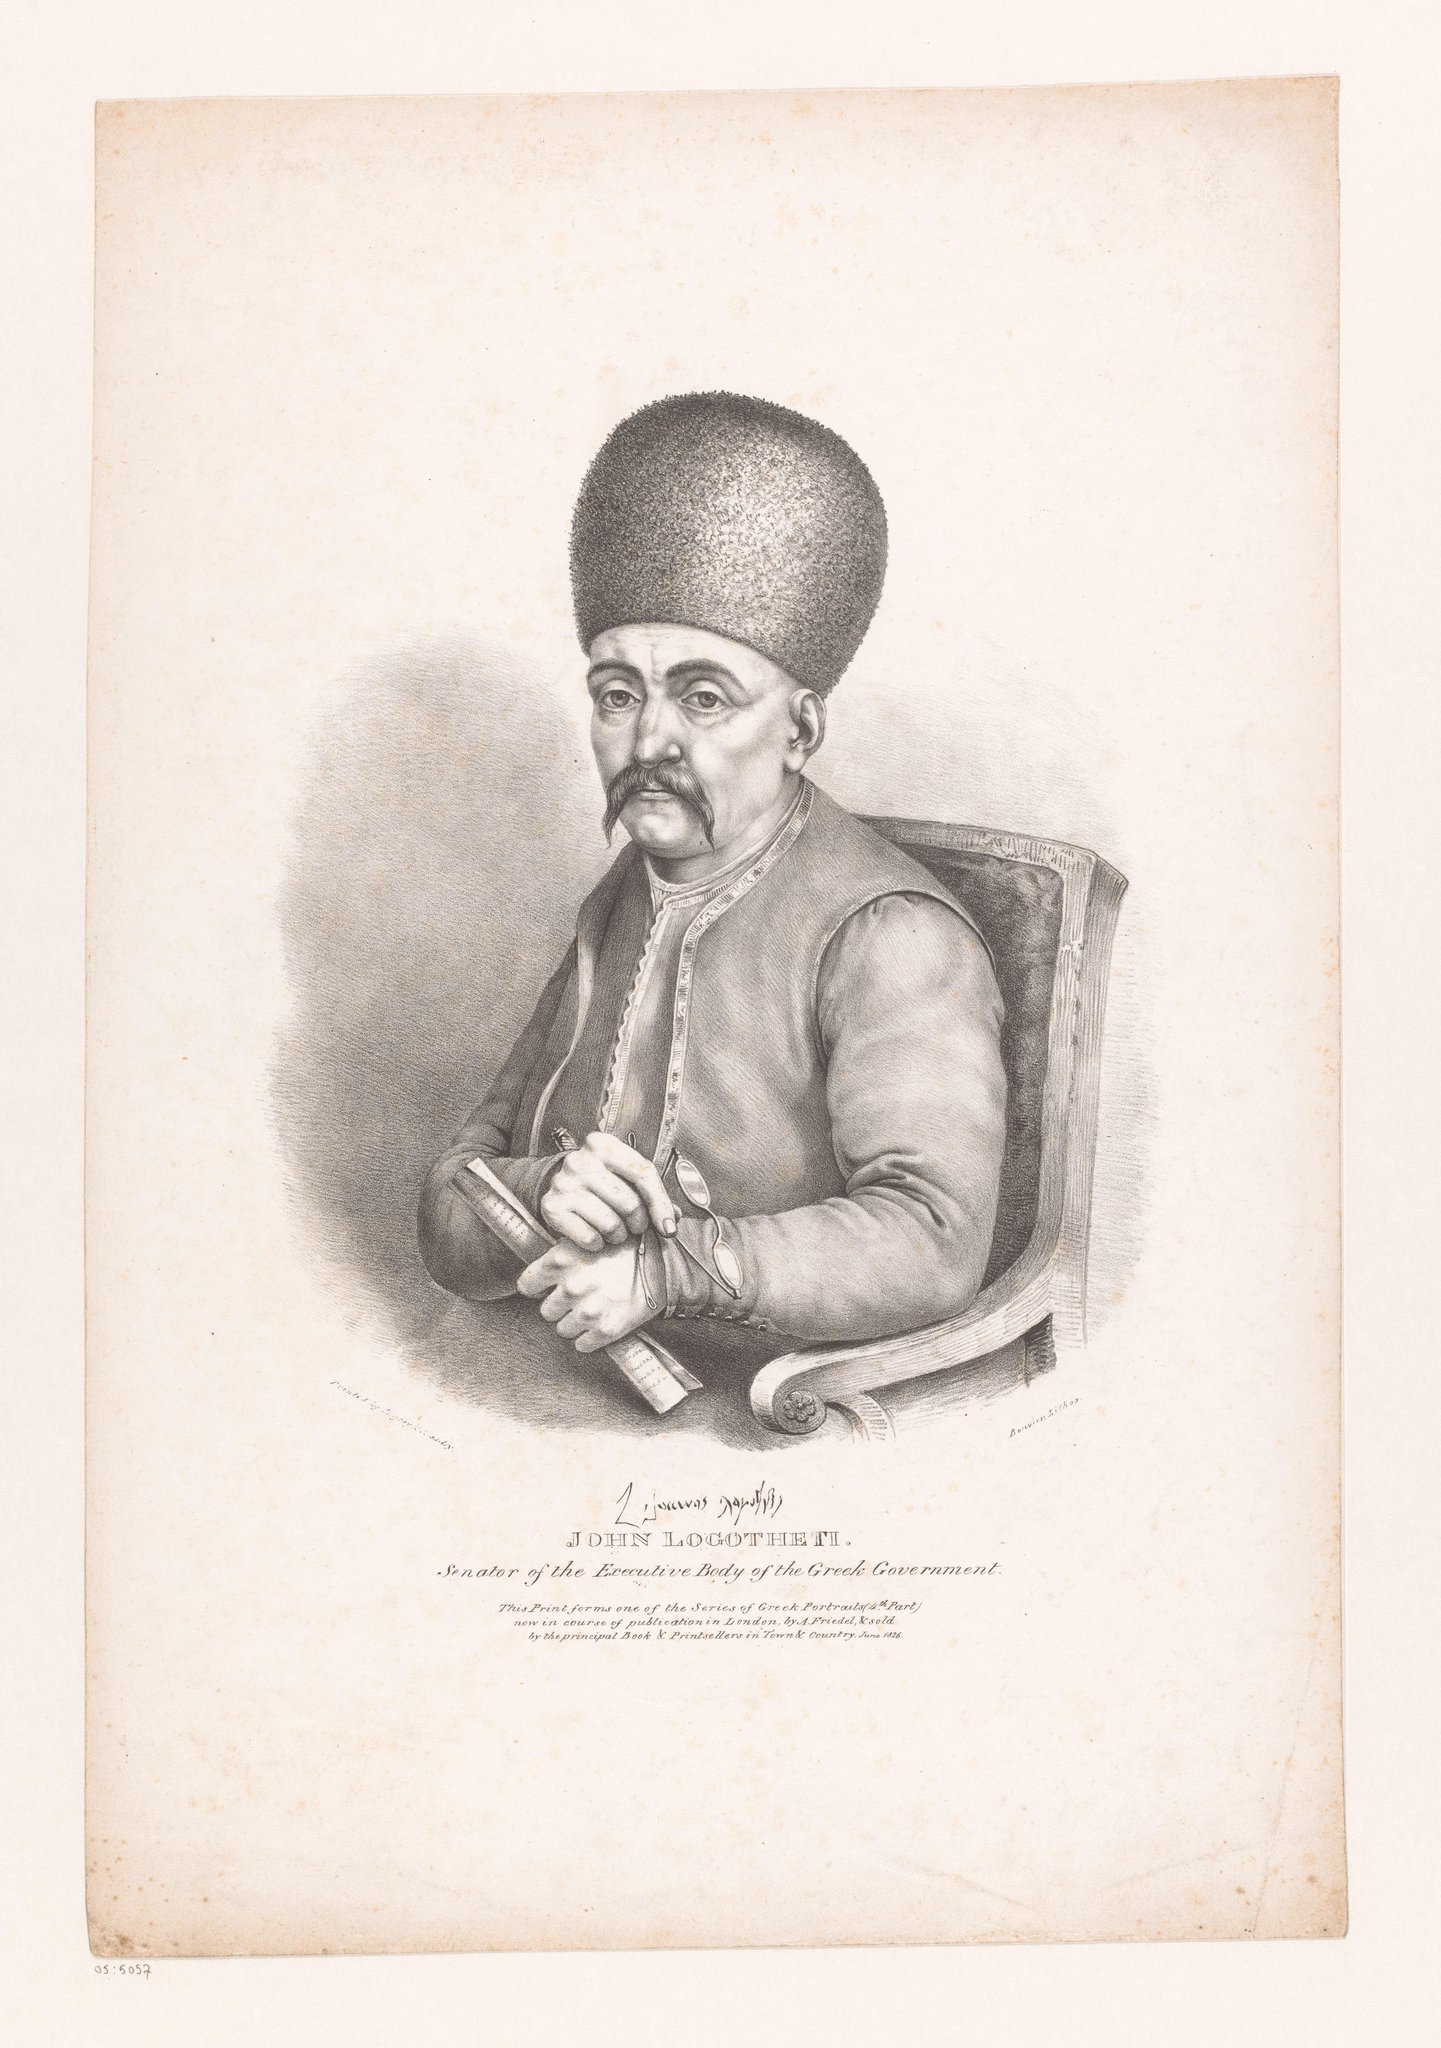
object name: print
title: Portretten van figuren betrokken bij de Griekse onafhankelijkheidsoorlog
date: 1826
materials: paper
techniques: lithograph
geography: london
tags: eyeglasses, spectacles, head-gear, moustache, adult man, historical persons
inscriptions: collector's mark: Lugt 2228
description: Prent maakt onderdeel uit van een serie portretten van figuren betrokken bij de Griekse onafhankelijkheidsoorlog. Deze serie is uitgegeven door Adam Friedel in verschillende delen en edities.